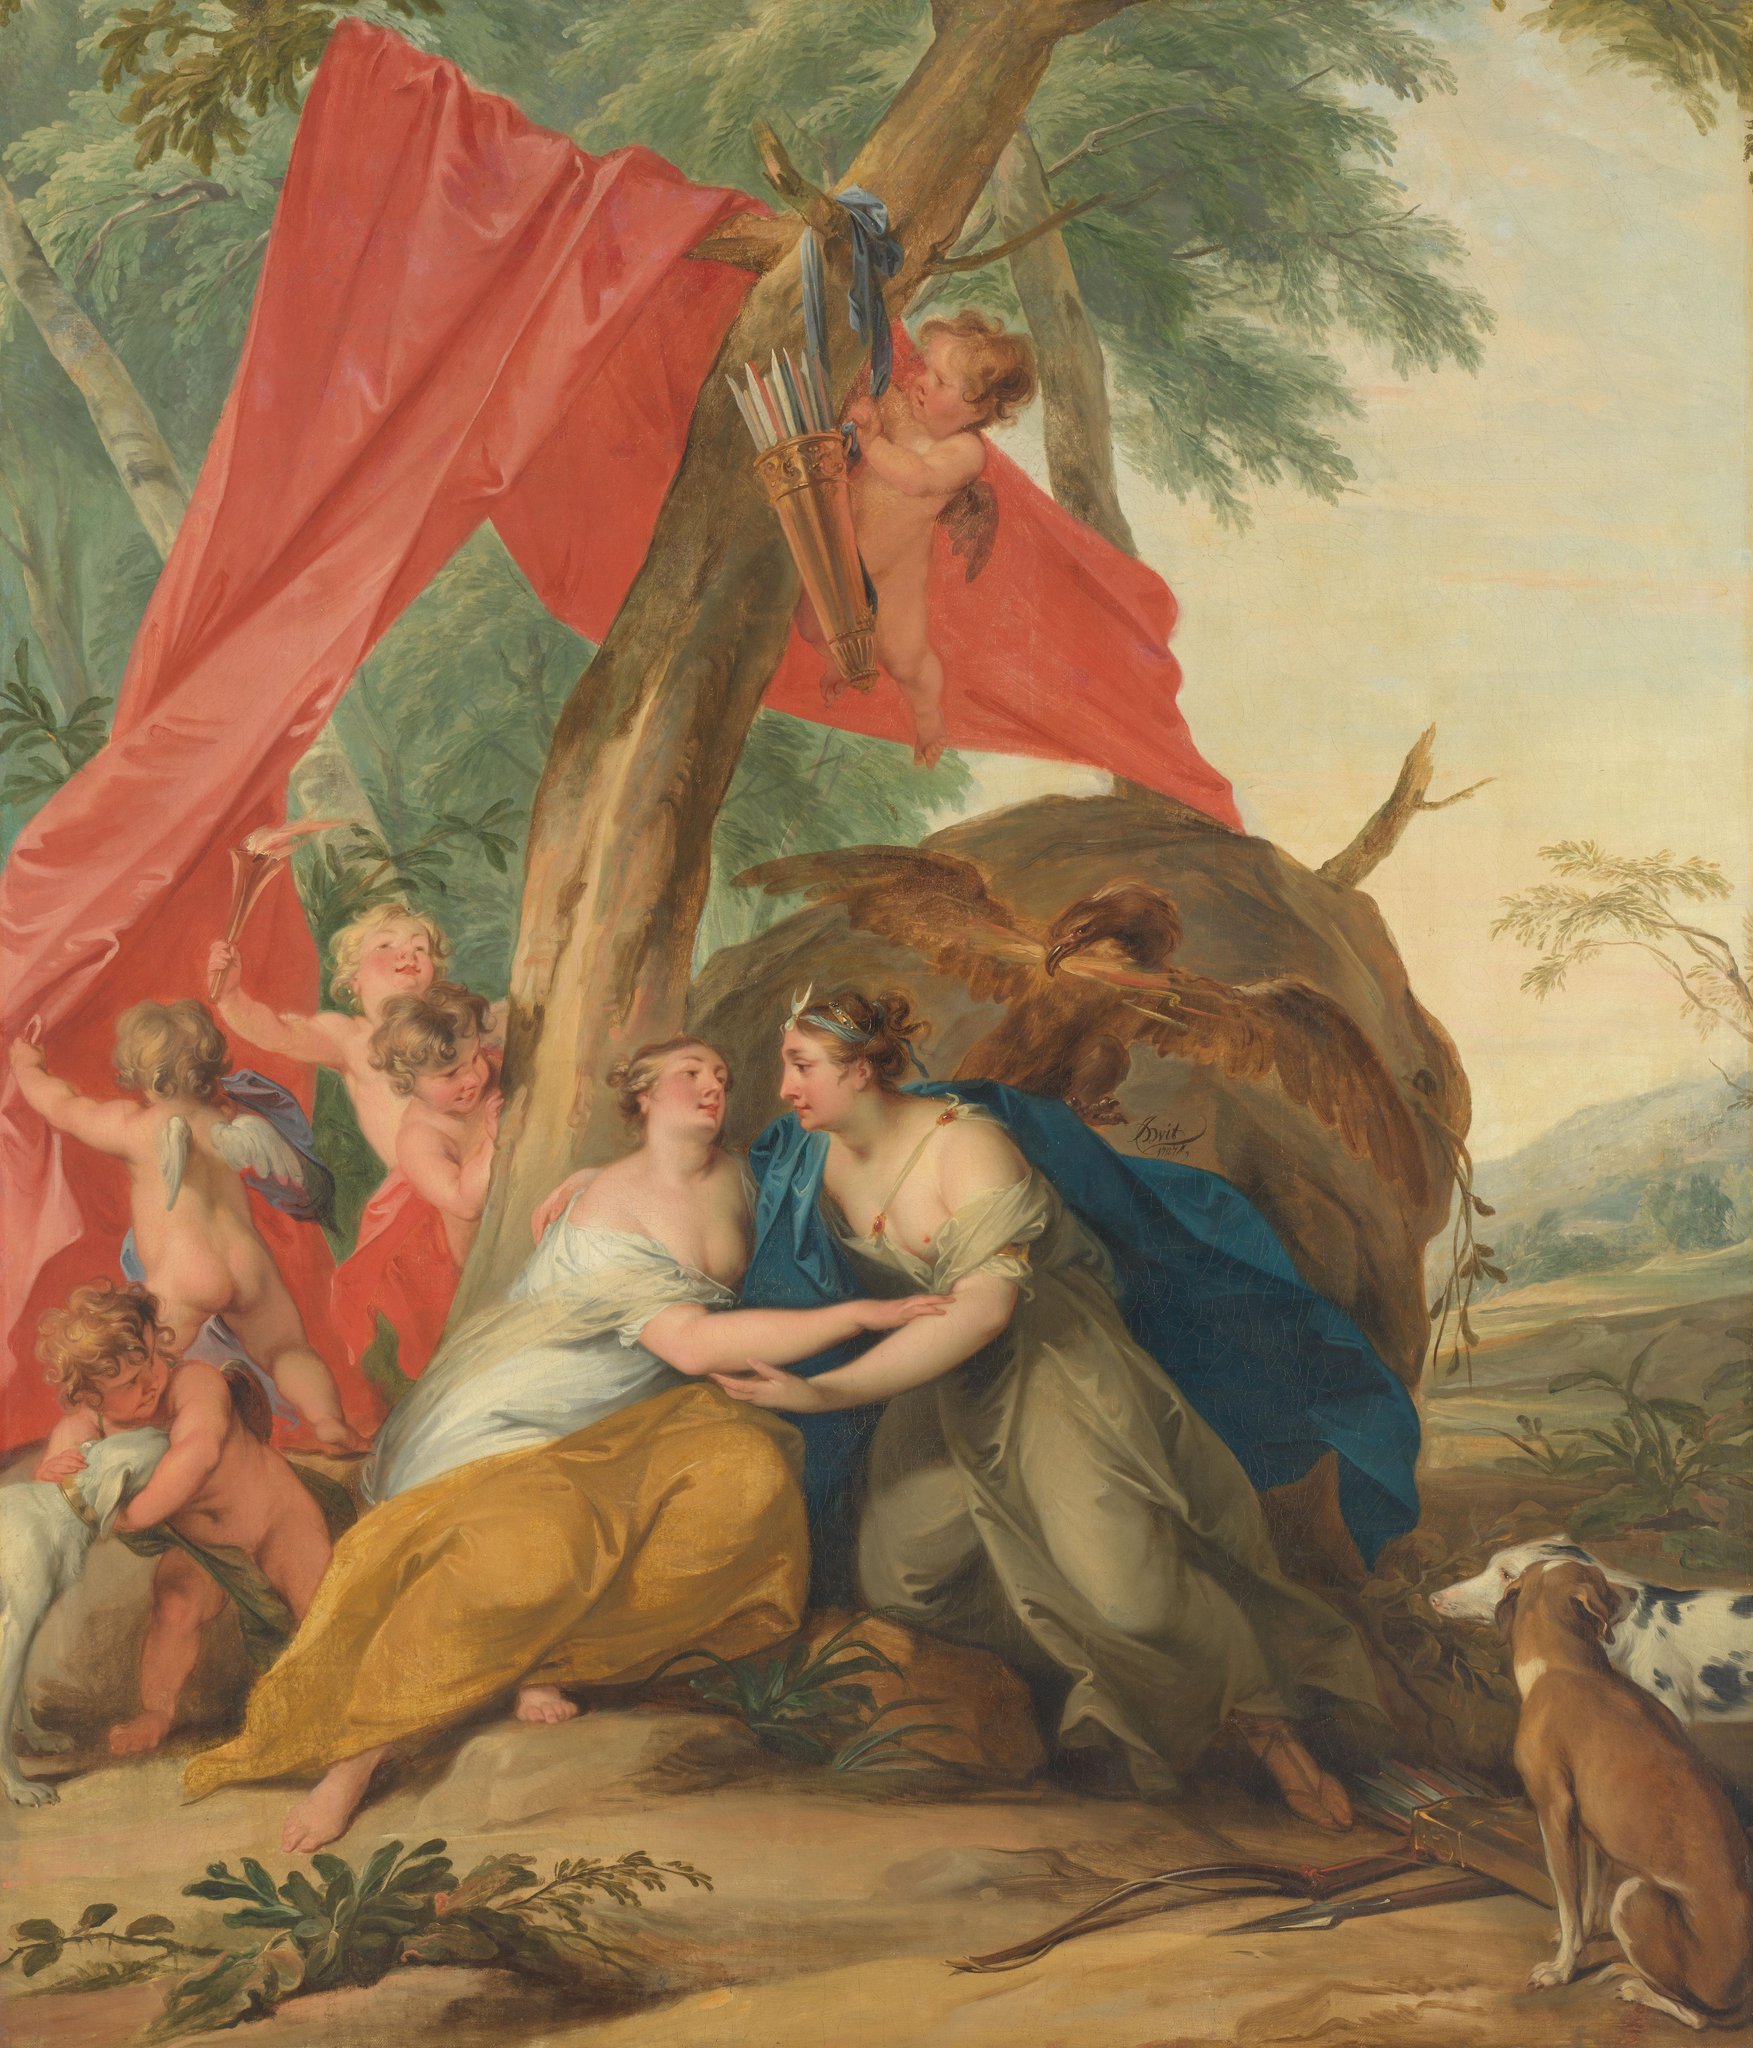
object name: painting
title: Jupiter, Disguised as Diana, Seducing the Nymph Callisto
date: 1727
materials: canvas, oil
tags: jupiter, in the guise of diana, and callisto, homosexual love - cc - homosexual love between women: lesbianism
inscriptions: signature and date, on the rock below the eagle: ‘JdWit 1727’ JdWit 1727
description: Jacob de Wit specialized in decorative paintings for town and country houses. He designed entire ensembles, with large paintings and overdoors set in panels. He decided where the paintings were to be placed and adapted the compositions and the fall of light accordingly. This painting and its pendant (to the left of the mantelpiece) were made for the country house of an Amsterdam citizen situated along the River Vecht.